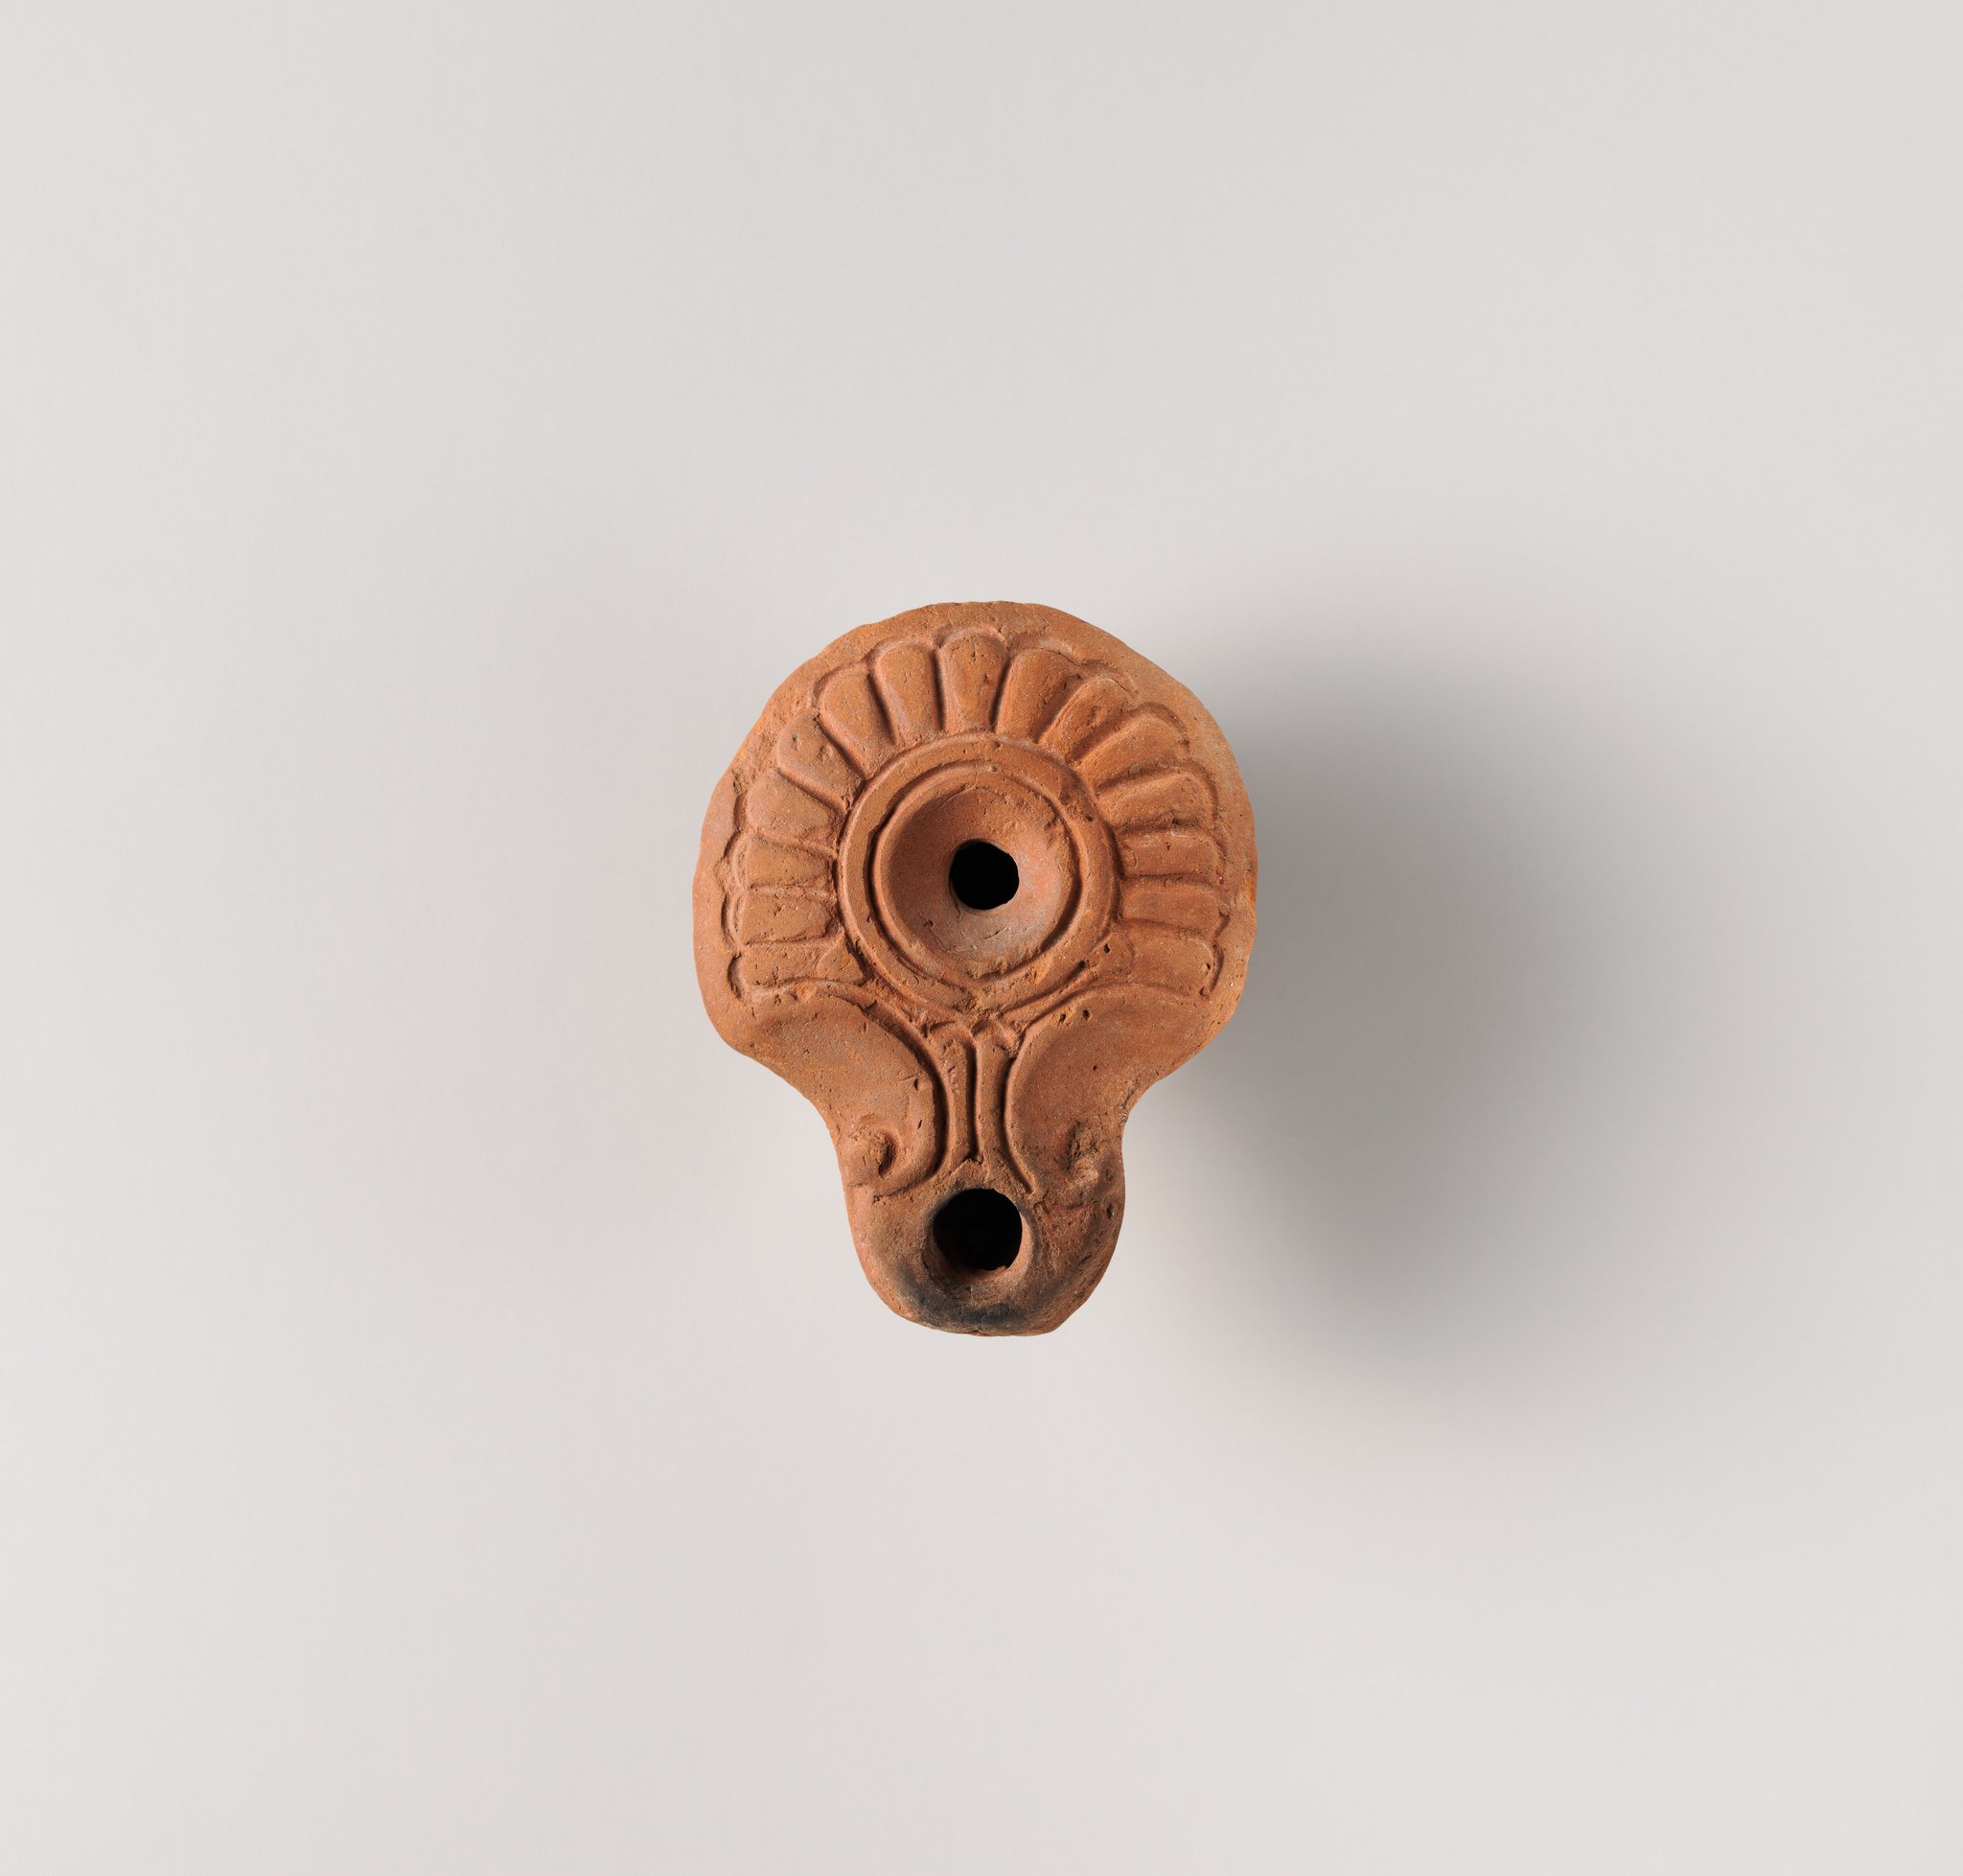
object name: lamp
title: Terracotta oil lamp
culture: roman, egyptian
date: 101-233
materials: terracotta